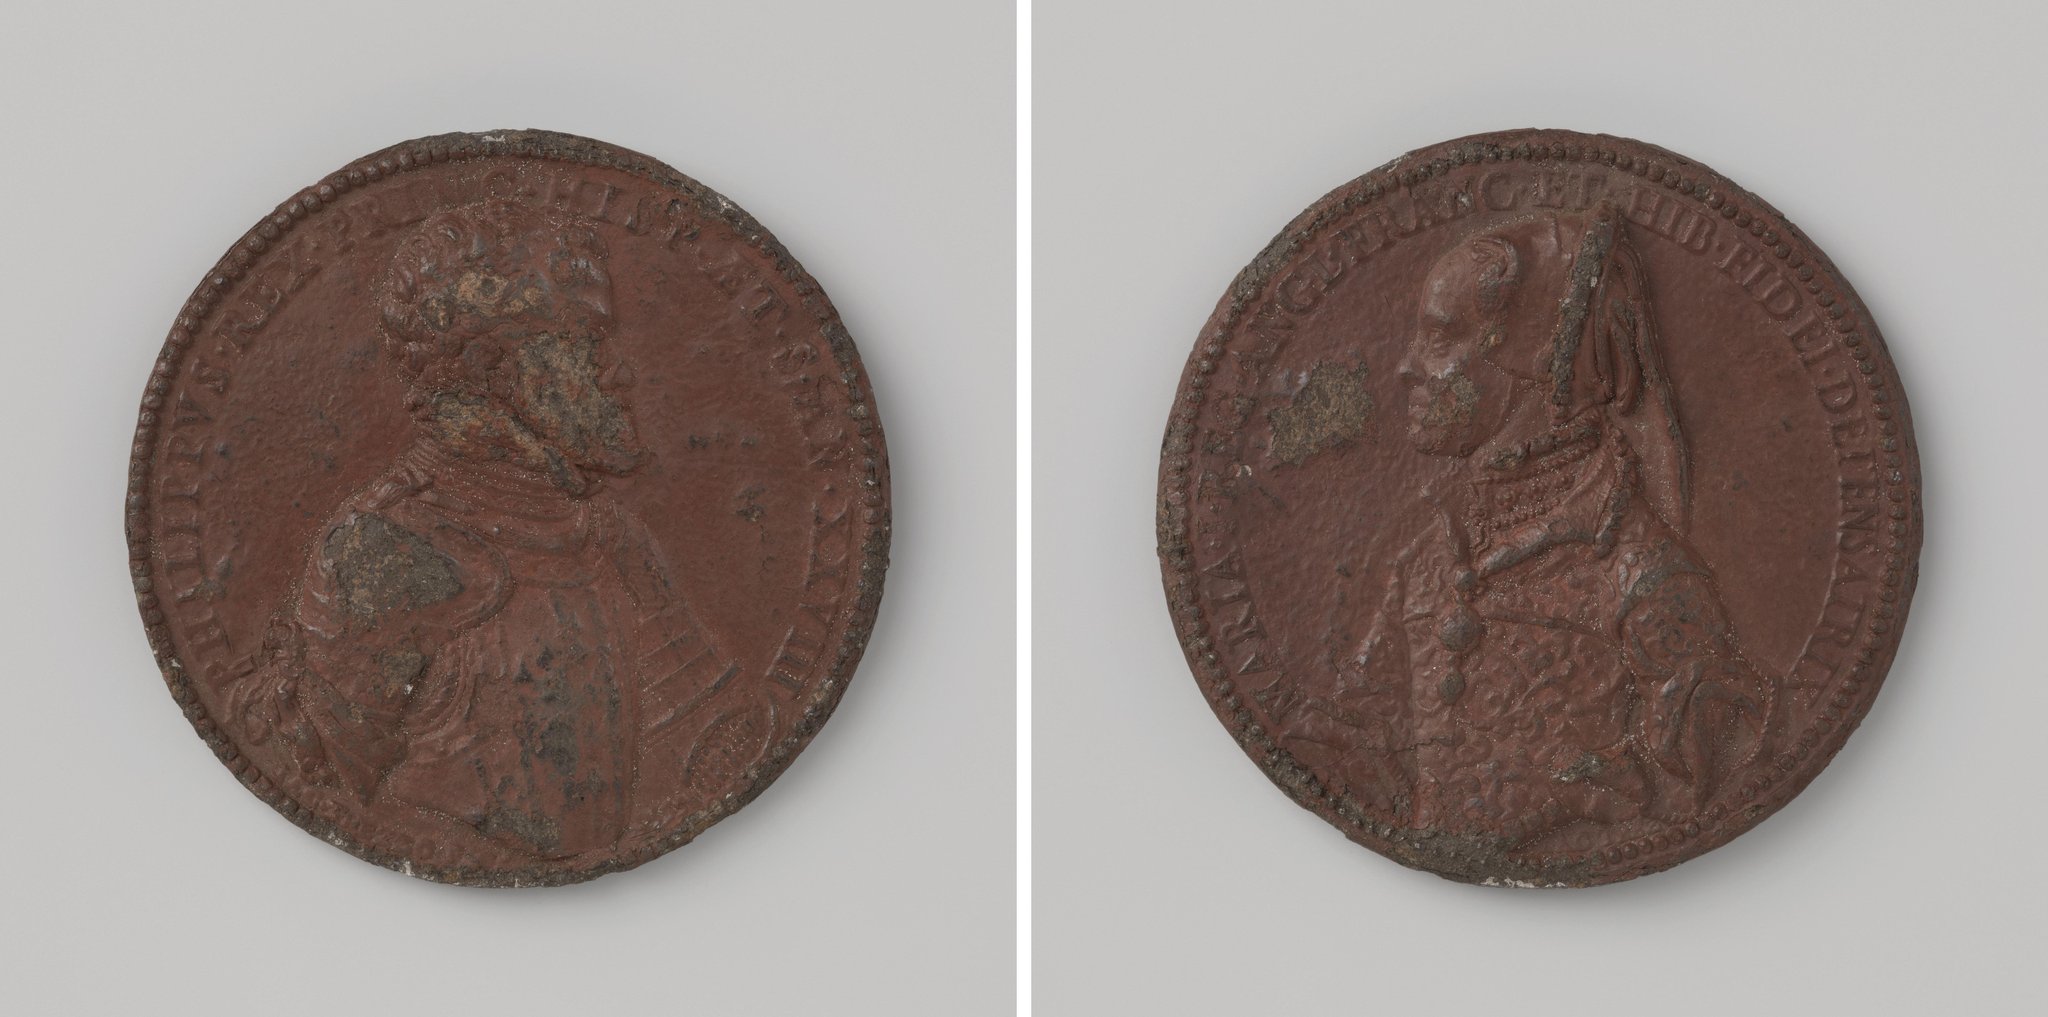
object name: history medal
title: Huwelijk van Philips II en Maria Tudor 1554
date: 1554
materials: tin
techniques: casting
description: Steenrood gelakte tinnen penning, op de voorzijde Philips ten halven lijve met omschrift, op de keerzijde Maria ten halven lijve met omschrift.